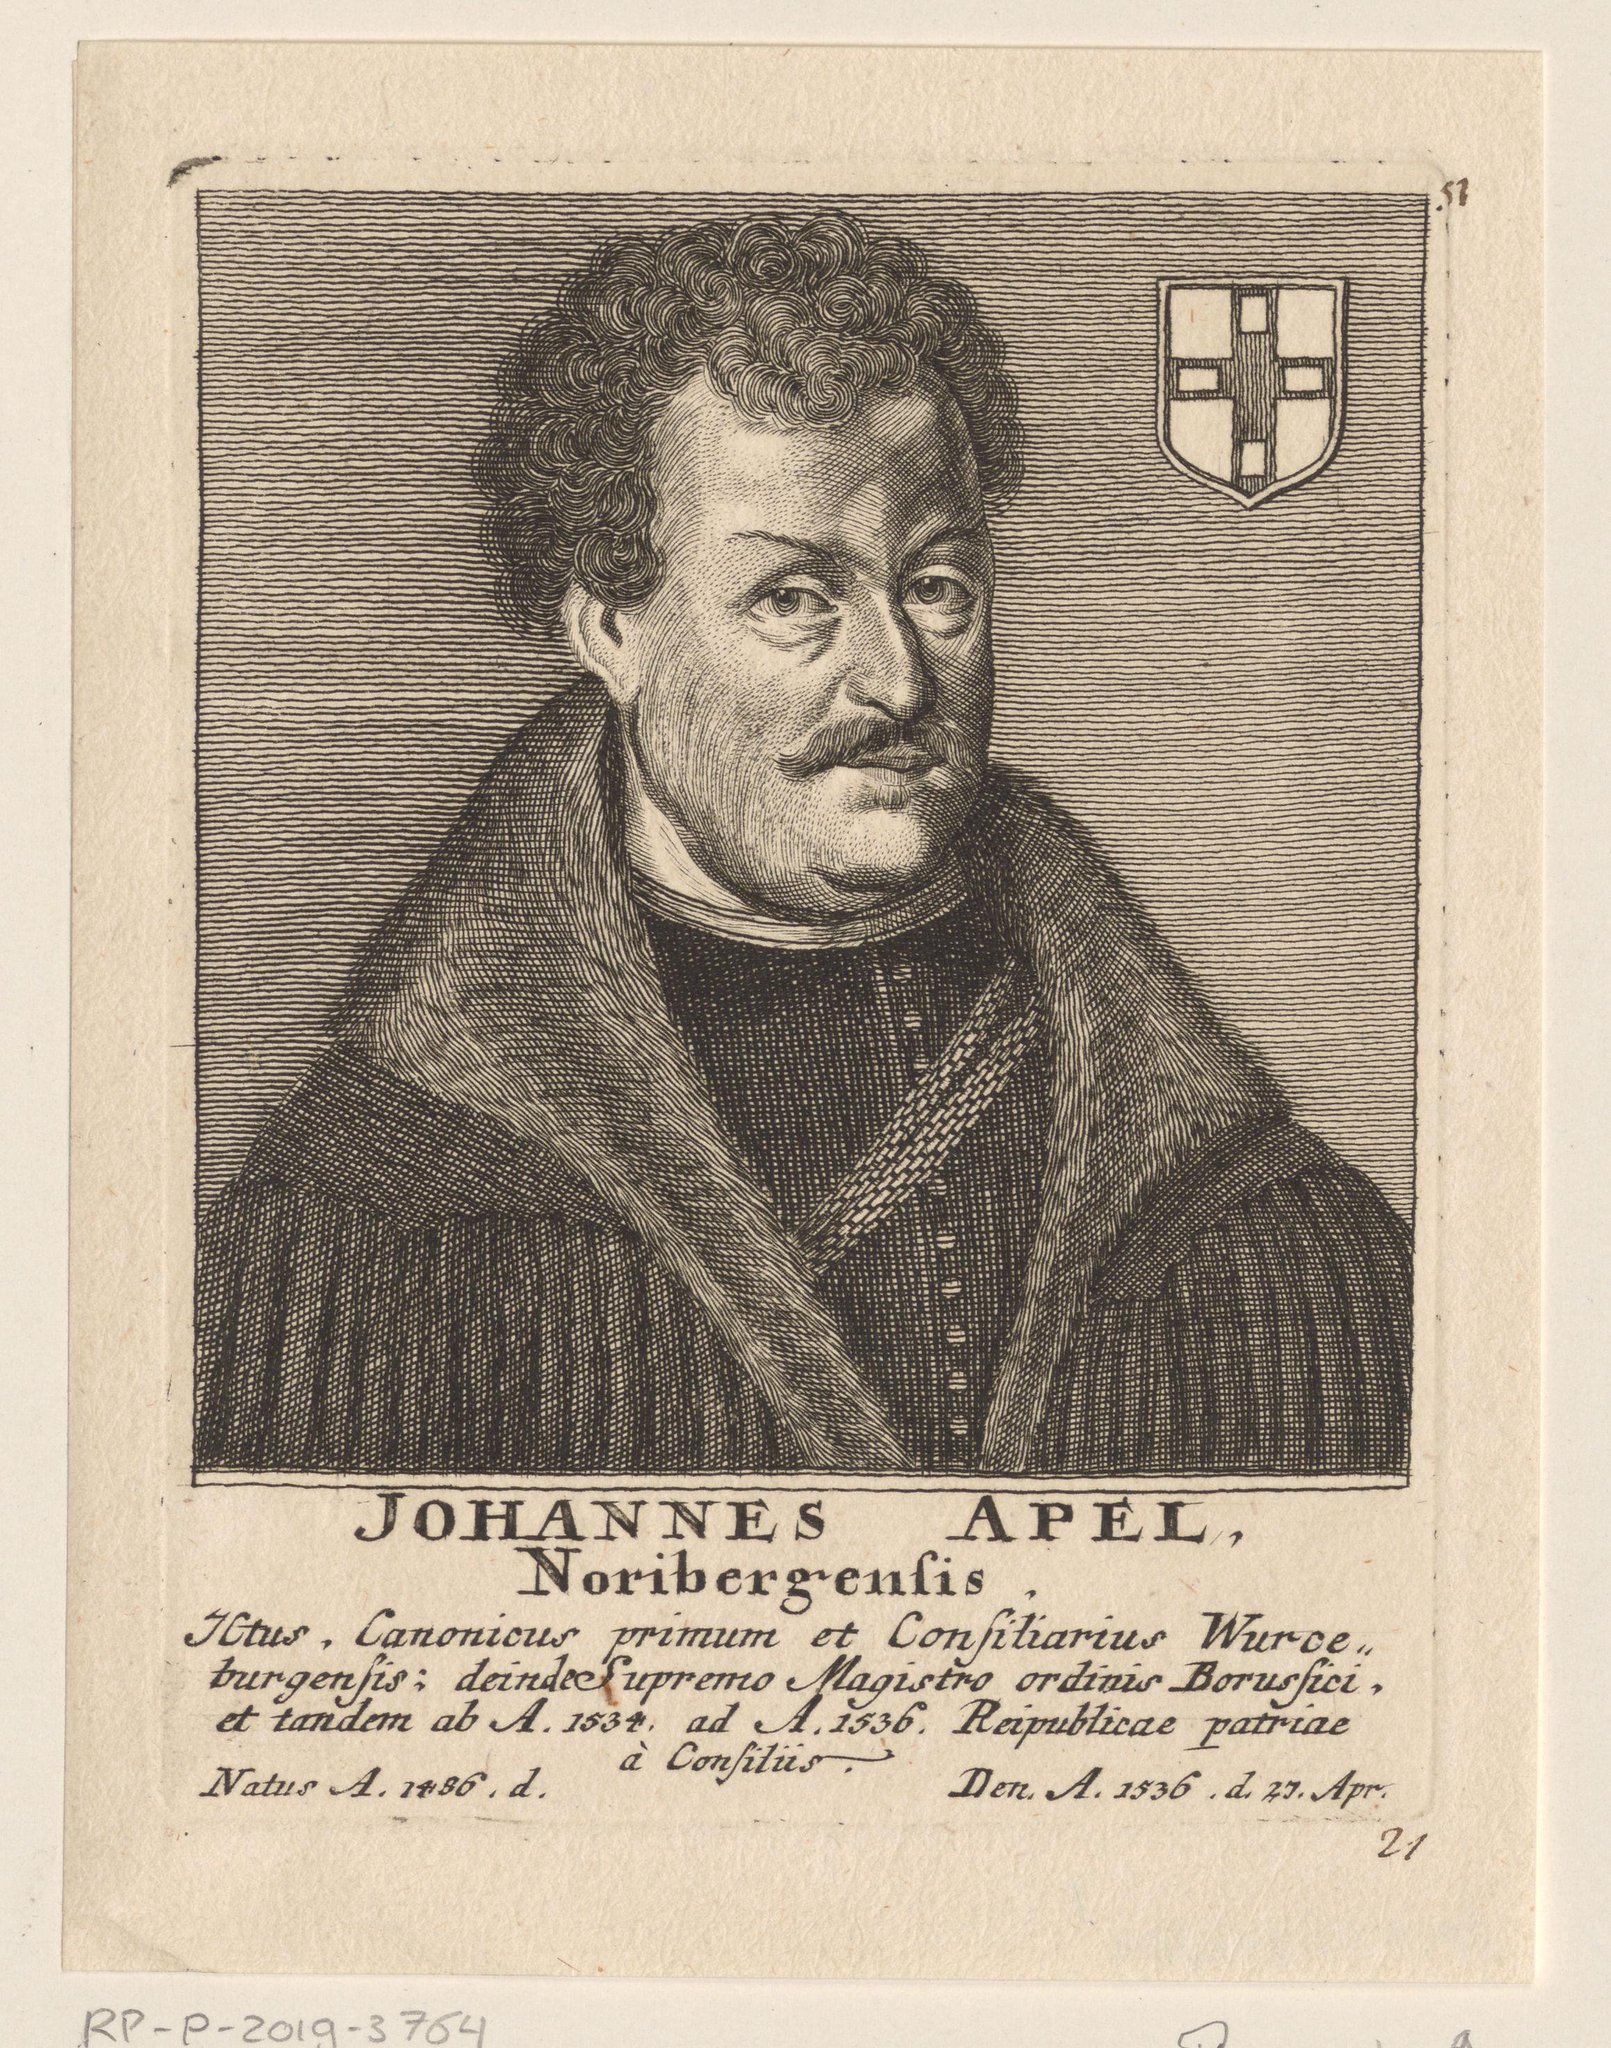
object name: print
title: Portret van Johann Apel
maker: Anonymous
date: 1600-1699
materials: paper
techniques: engraving, etching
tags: historical persons, armorial bearing, heraldry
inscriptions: inscription: ‘21’, inscription: ‘51’